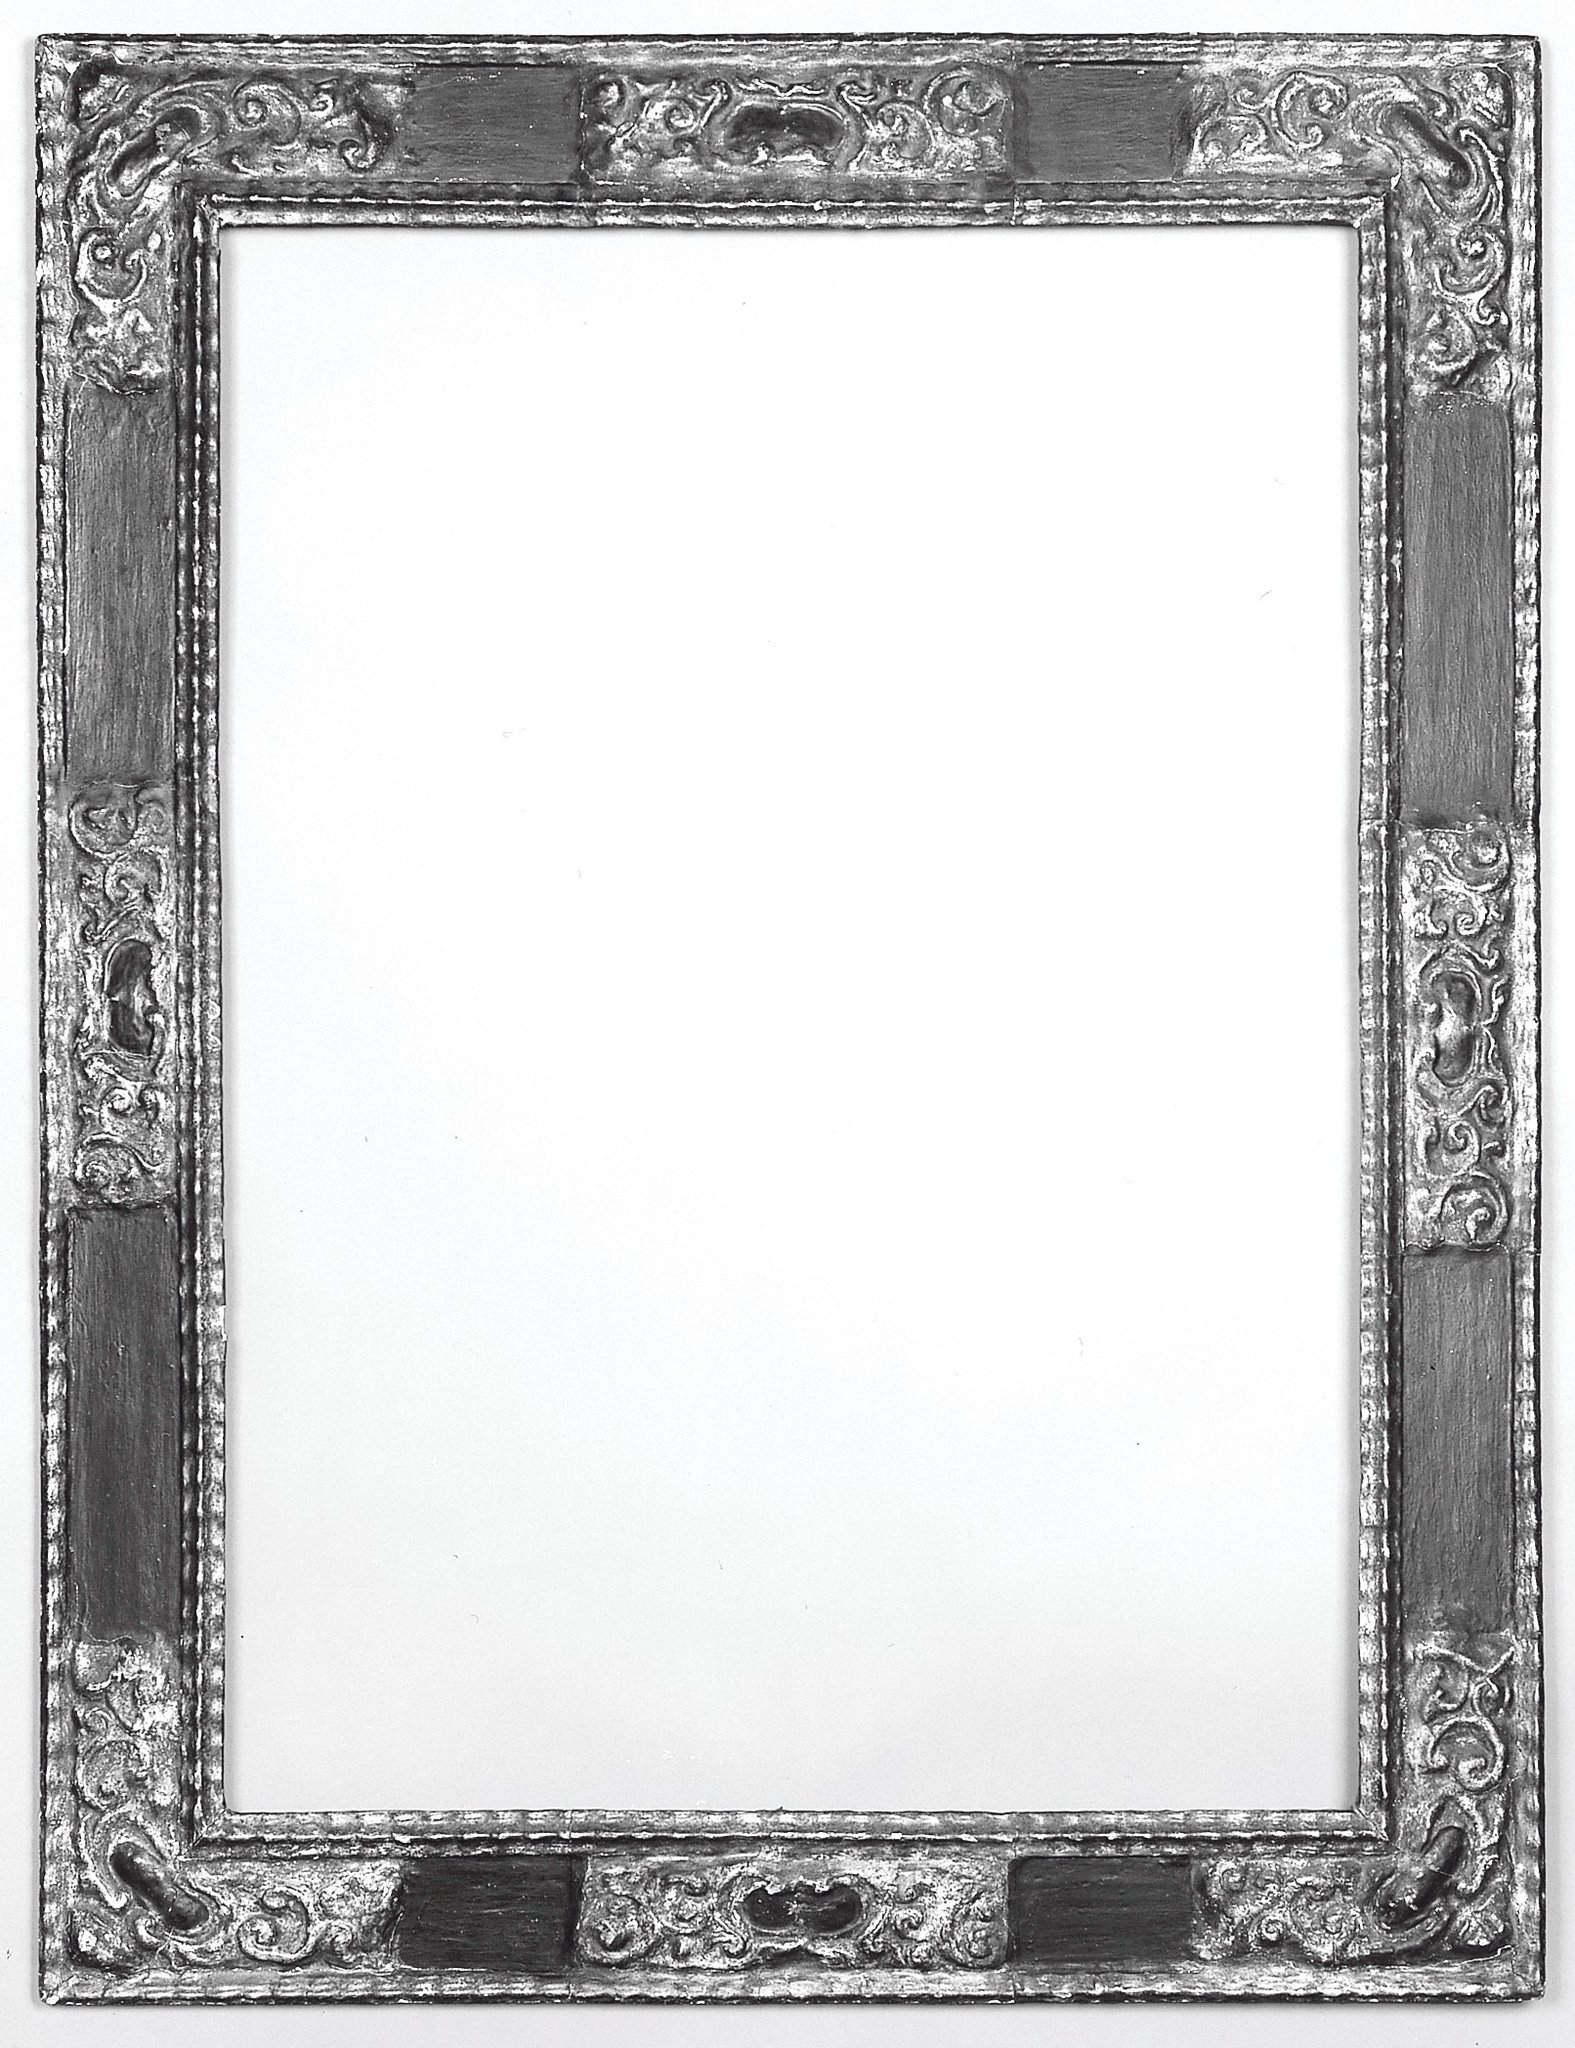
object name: frame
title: Reverse molding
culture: british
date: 1910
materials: wood